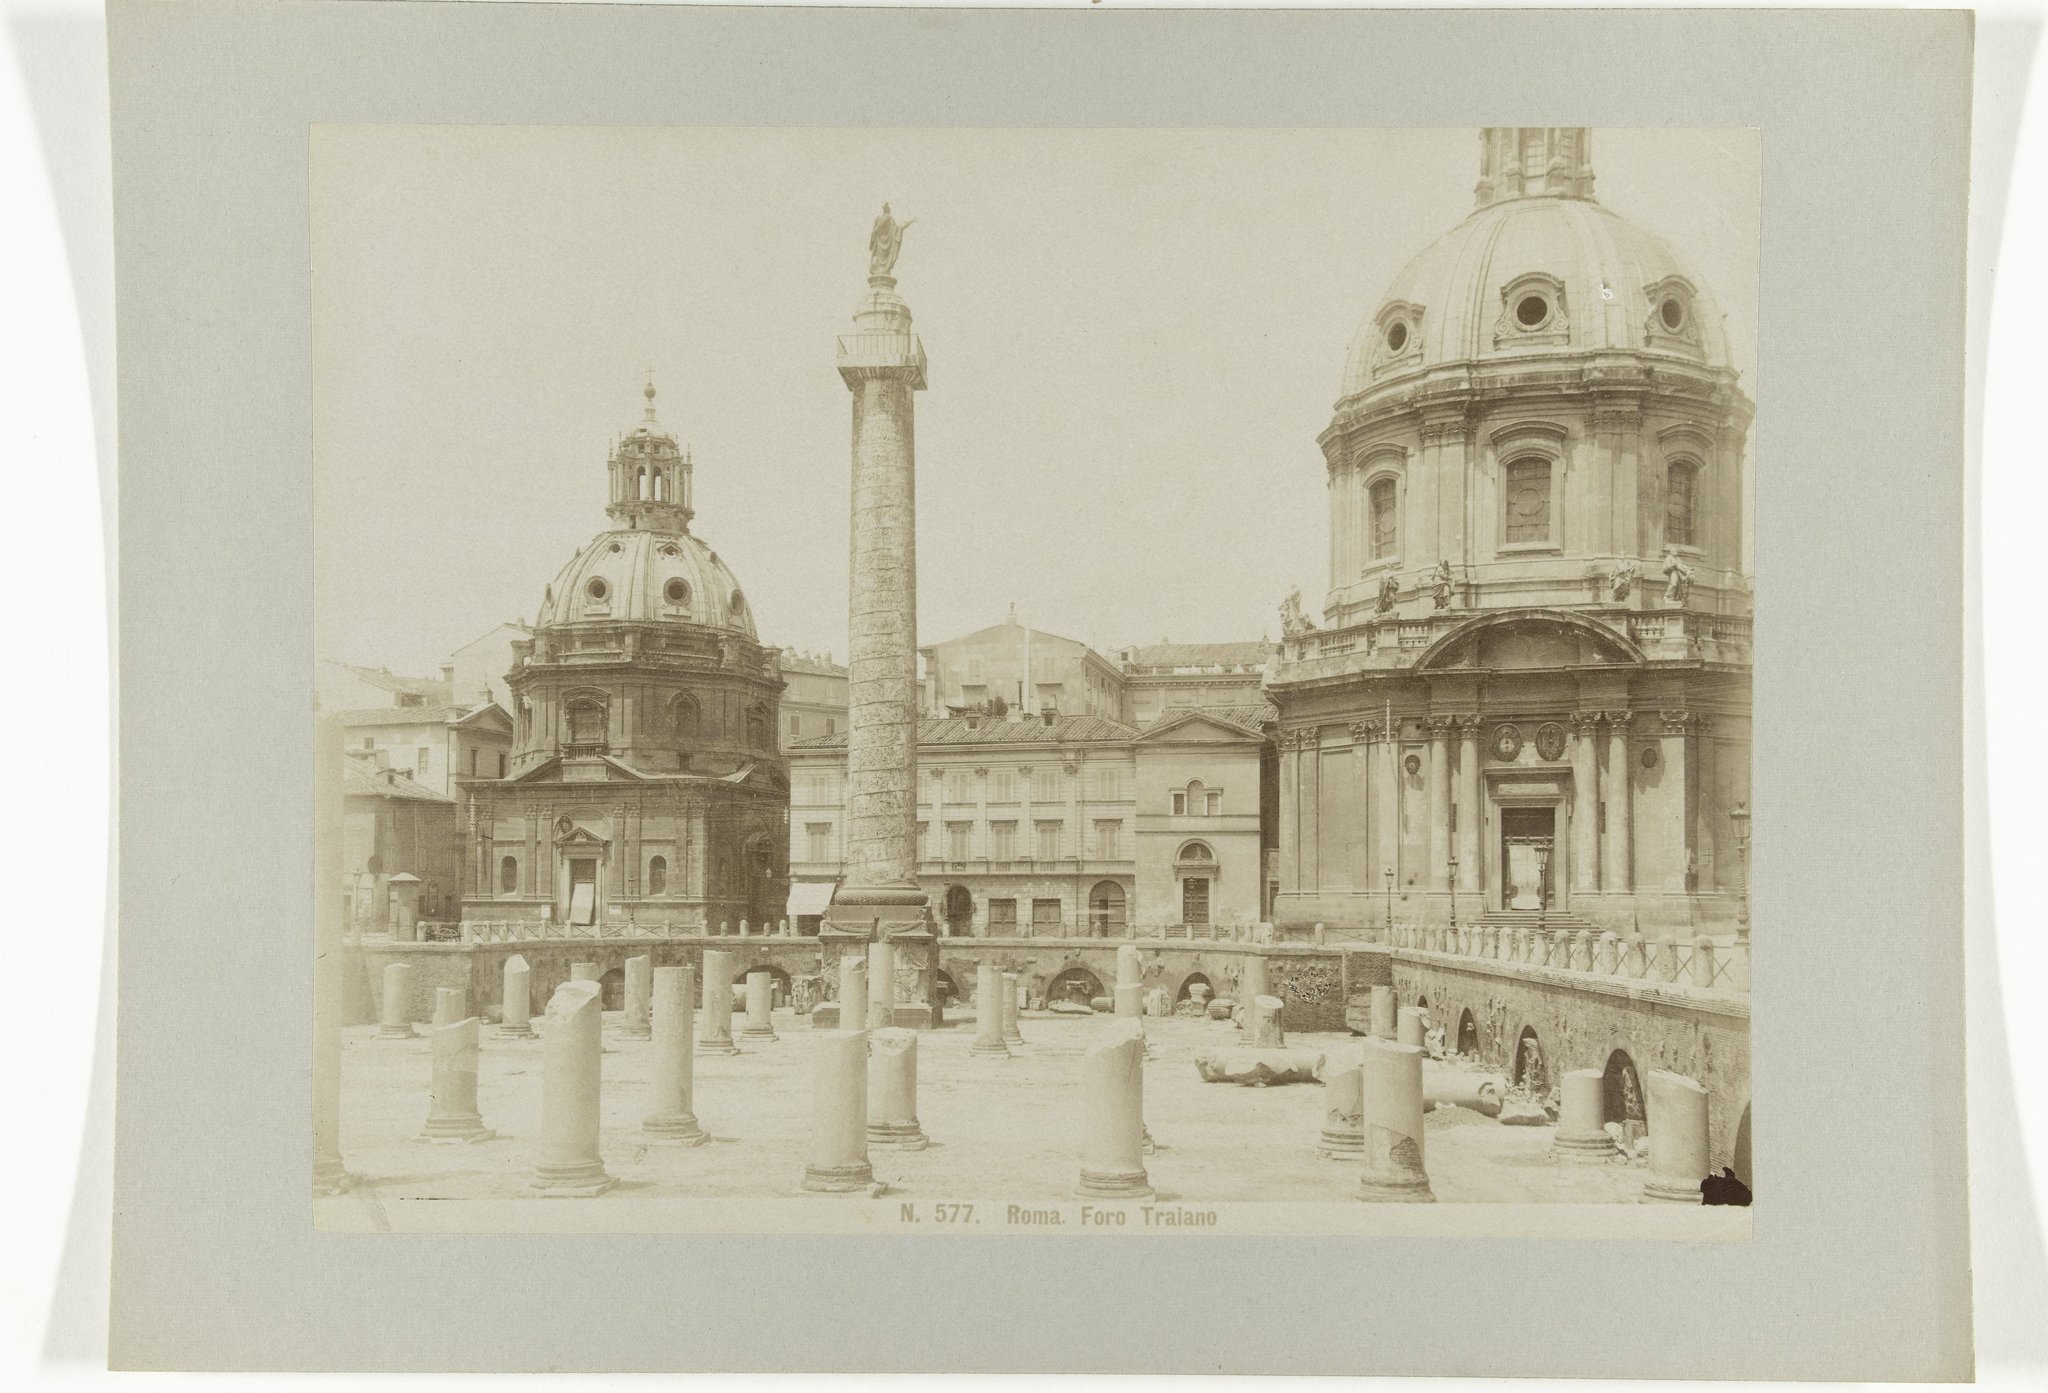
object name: photograph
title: N. 577. Roma. Foro Traiano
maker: Anonymous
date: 1880-1904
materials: cardboard, paper, photographic support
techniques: albumen print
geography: rome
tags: forum van trajanus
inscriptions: number: ‘28.’